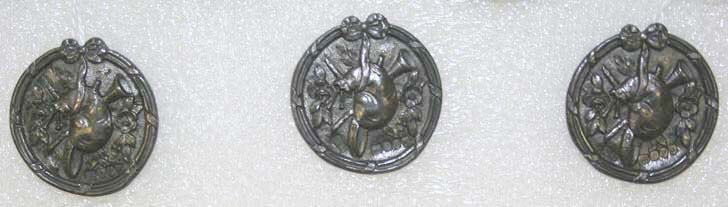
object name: button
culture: french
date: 1785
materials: metal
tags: bagpipes